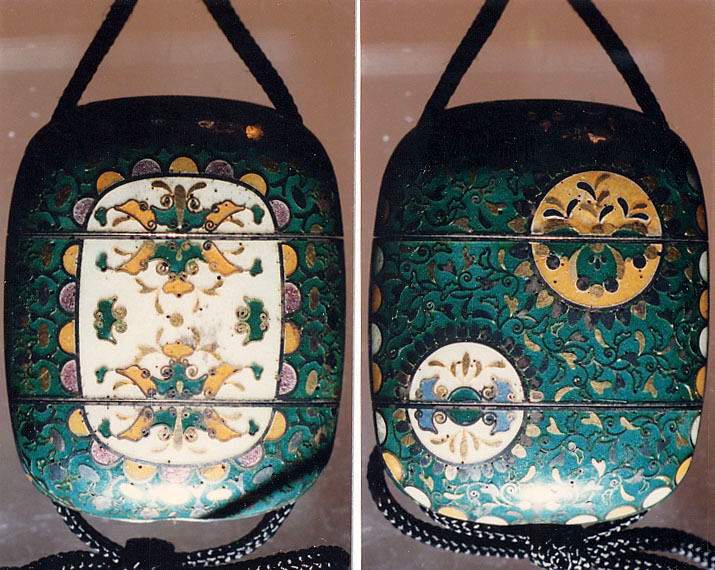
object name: inrō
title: Case (Inrō) with Design of Stylized Flowers and Scrolls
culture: japanese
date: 1801-1900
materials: enamel, metal, silver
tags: flowers